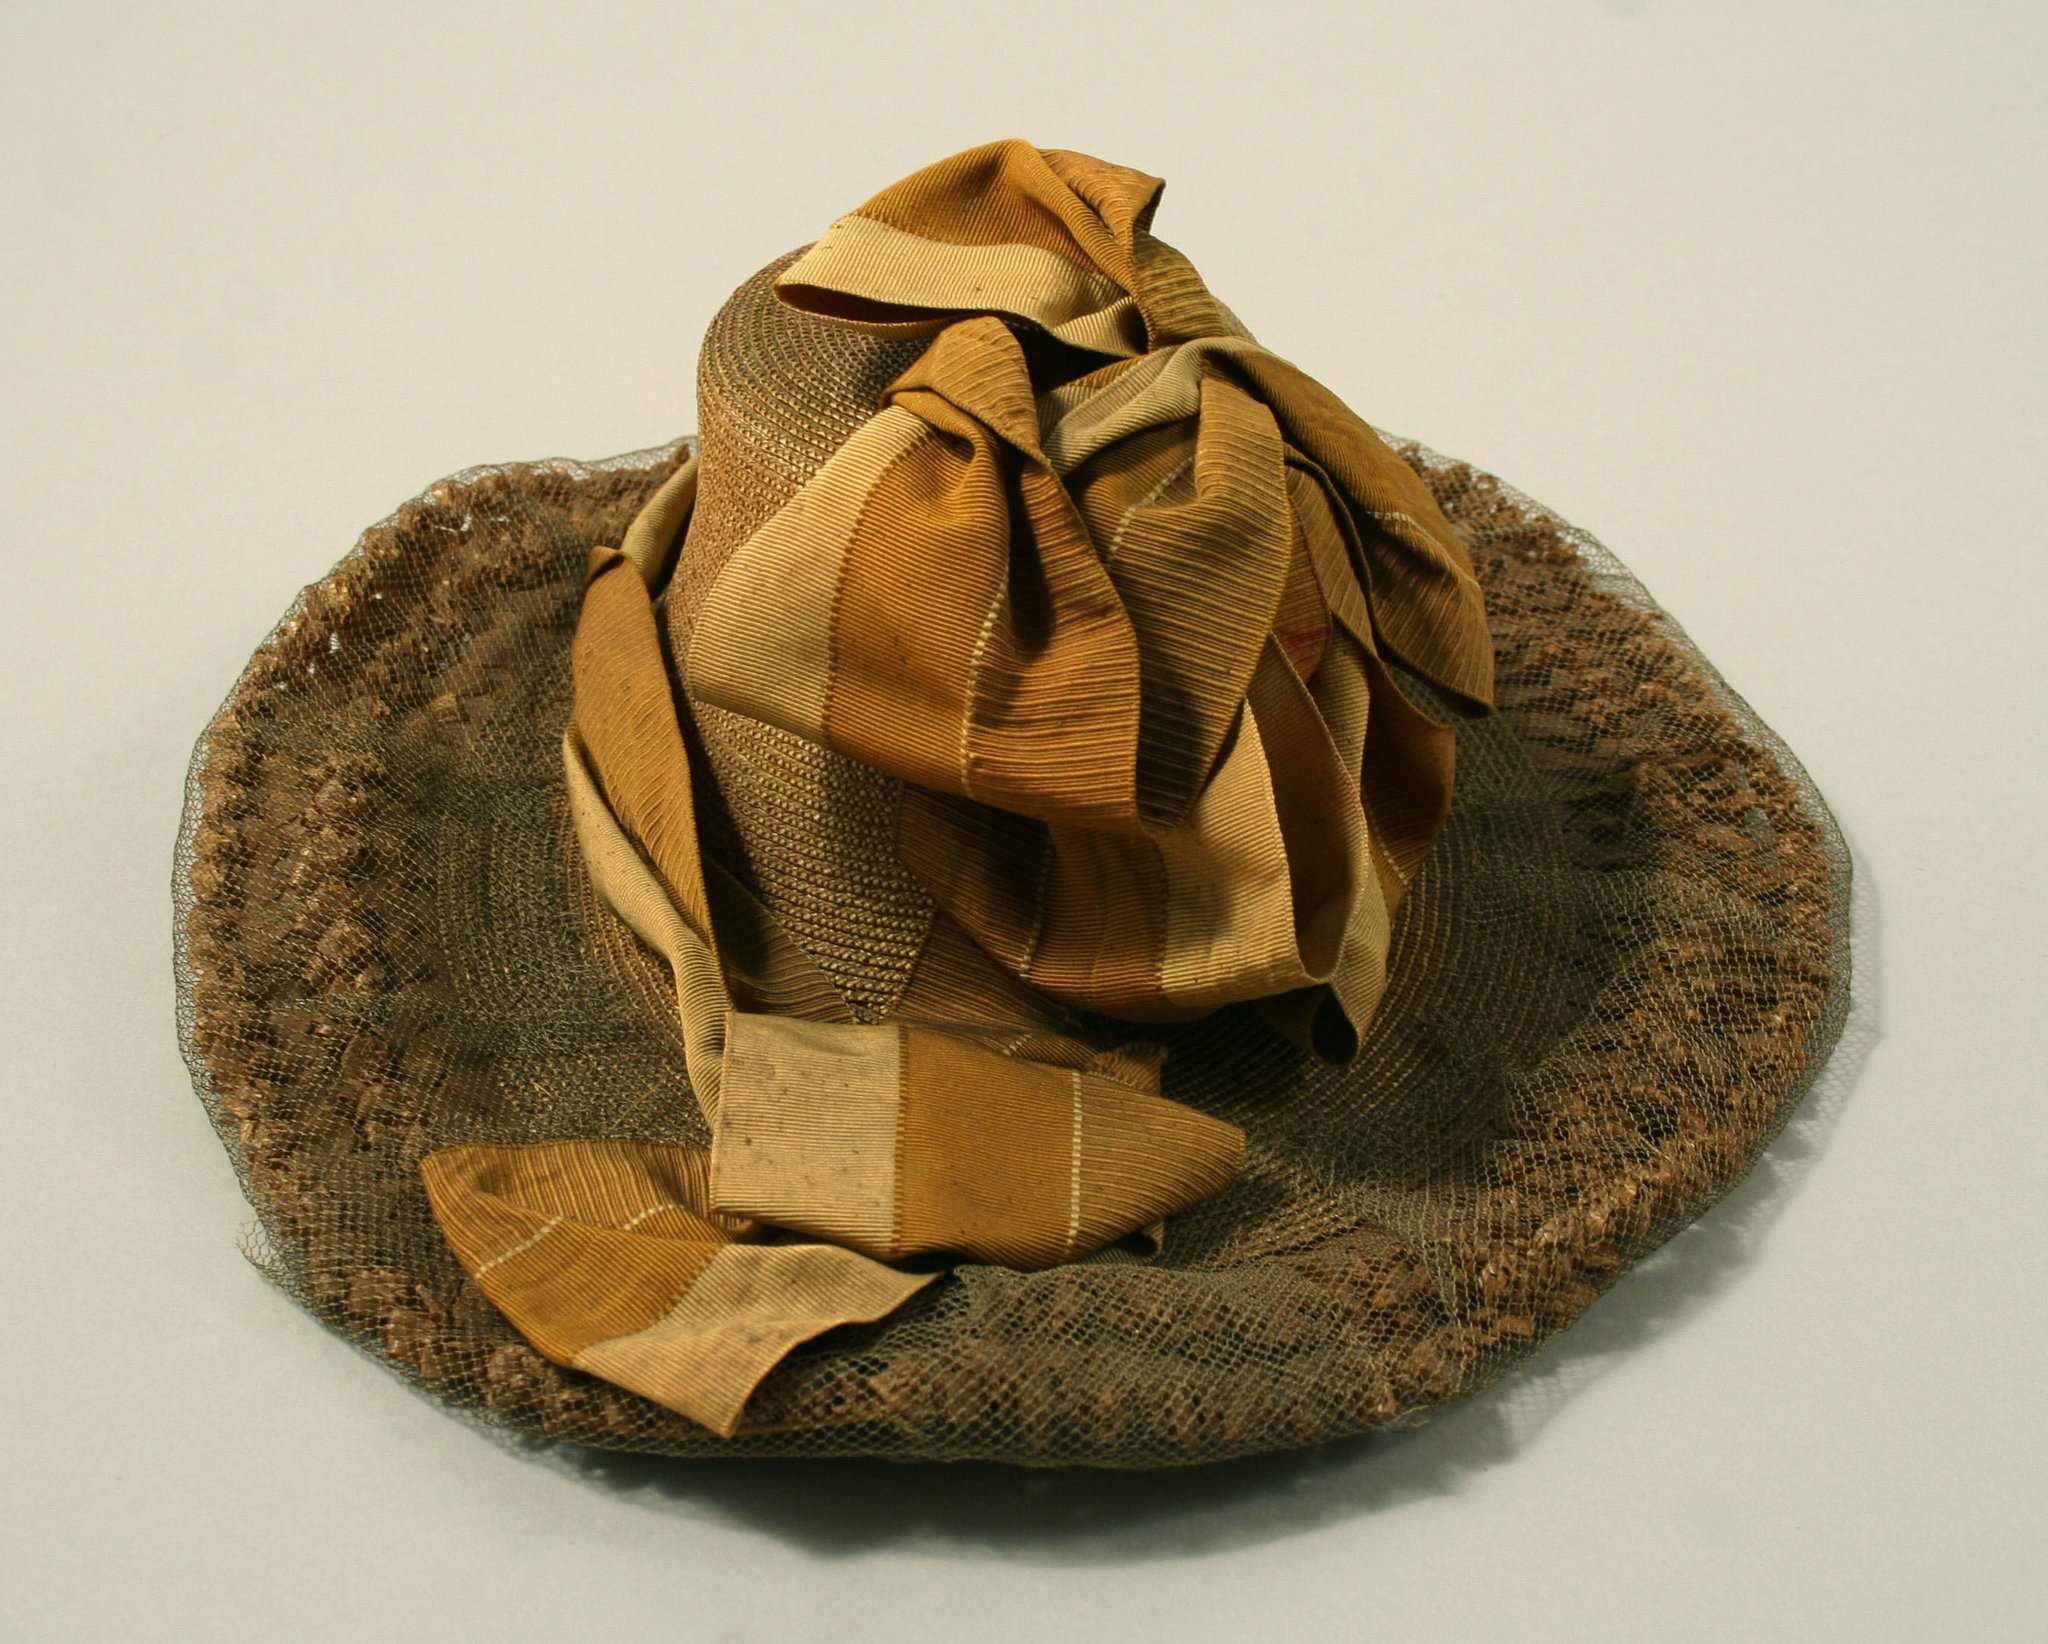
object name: hat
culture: american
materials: fiber